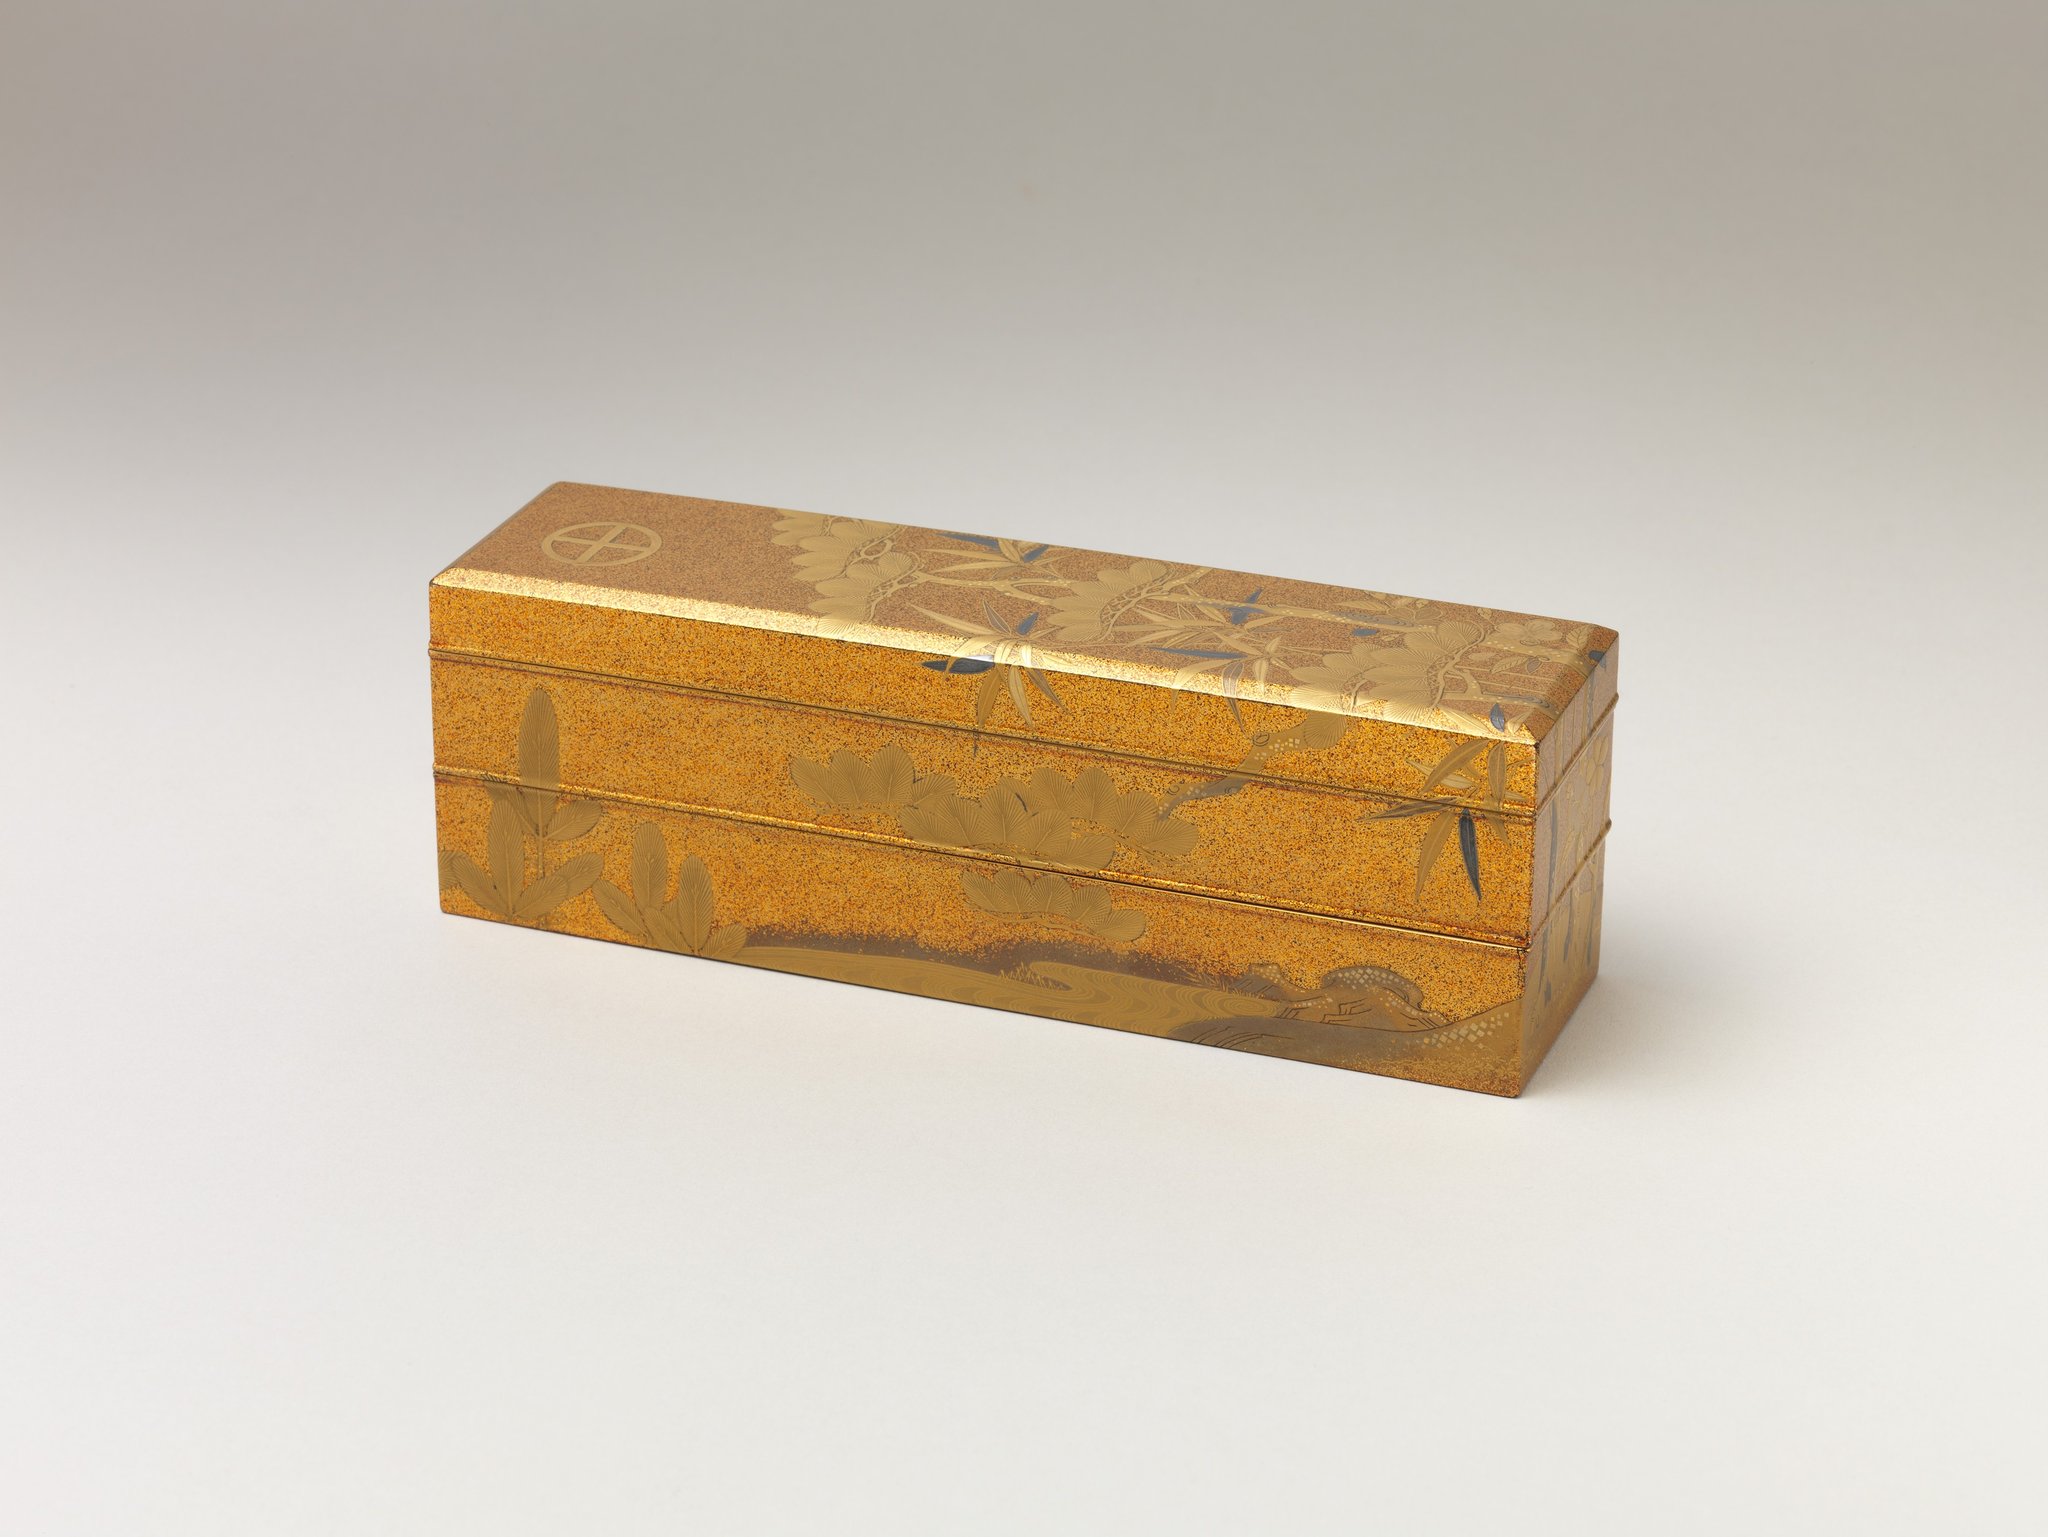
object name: box with cover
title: Covered Box with Design of Pine, Bamboo, and Cherry Blossom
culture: japanese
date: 1801-1900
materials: gold, lacquer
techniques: maki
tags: flowers,bamboo